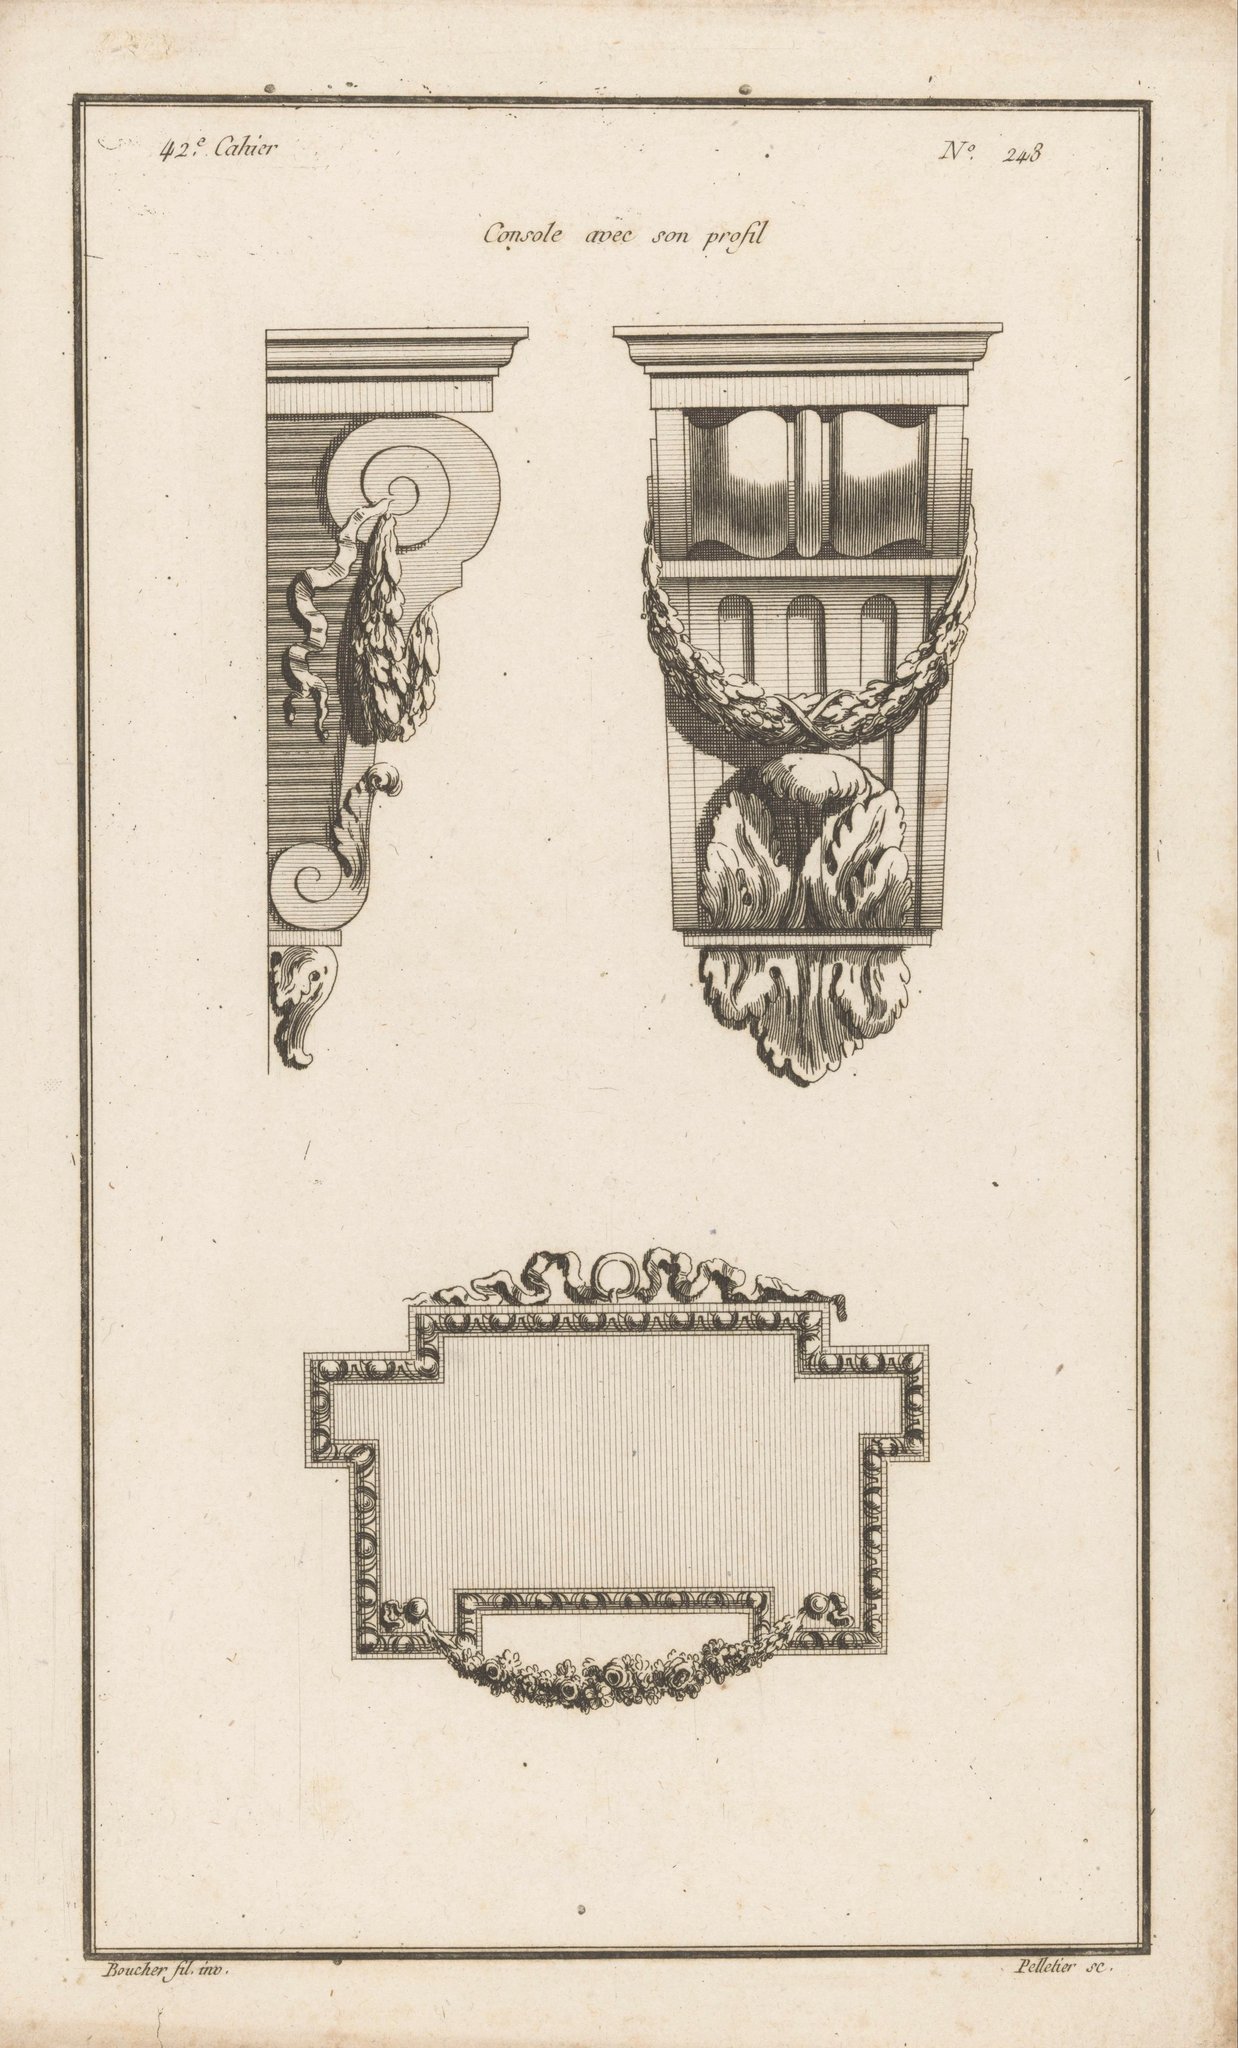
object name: print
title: 42e Cahier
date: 1772-1779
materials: paper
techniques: engraving, etching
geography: paris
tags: foliage ~ ornament, other architectural details (console), ornament ~ festoon, garland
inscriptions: collector's mark: Lugt 2760, collector's mark: Lugt 2228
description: Zij- en vooraanzicht van een console met bladmotieven en een guirlande. Daaronder een tablet met eierlijst en guirlande. Prentnummer 248.